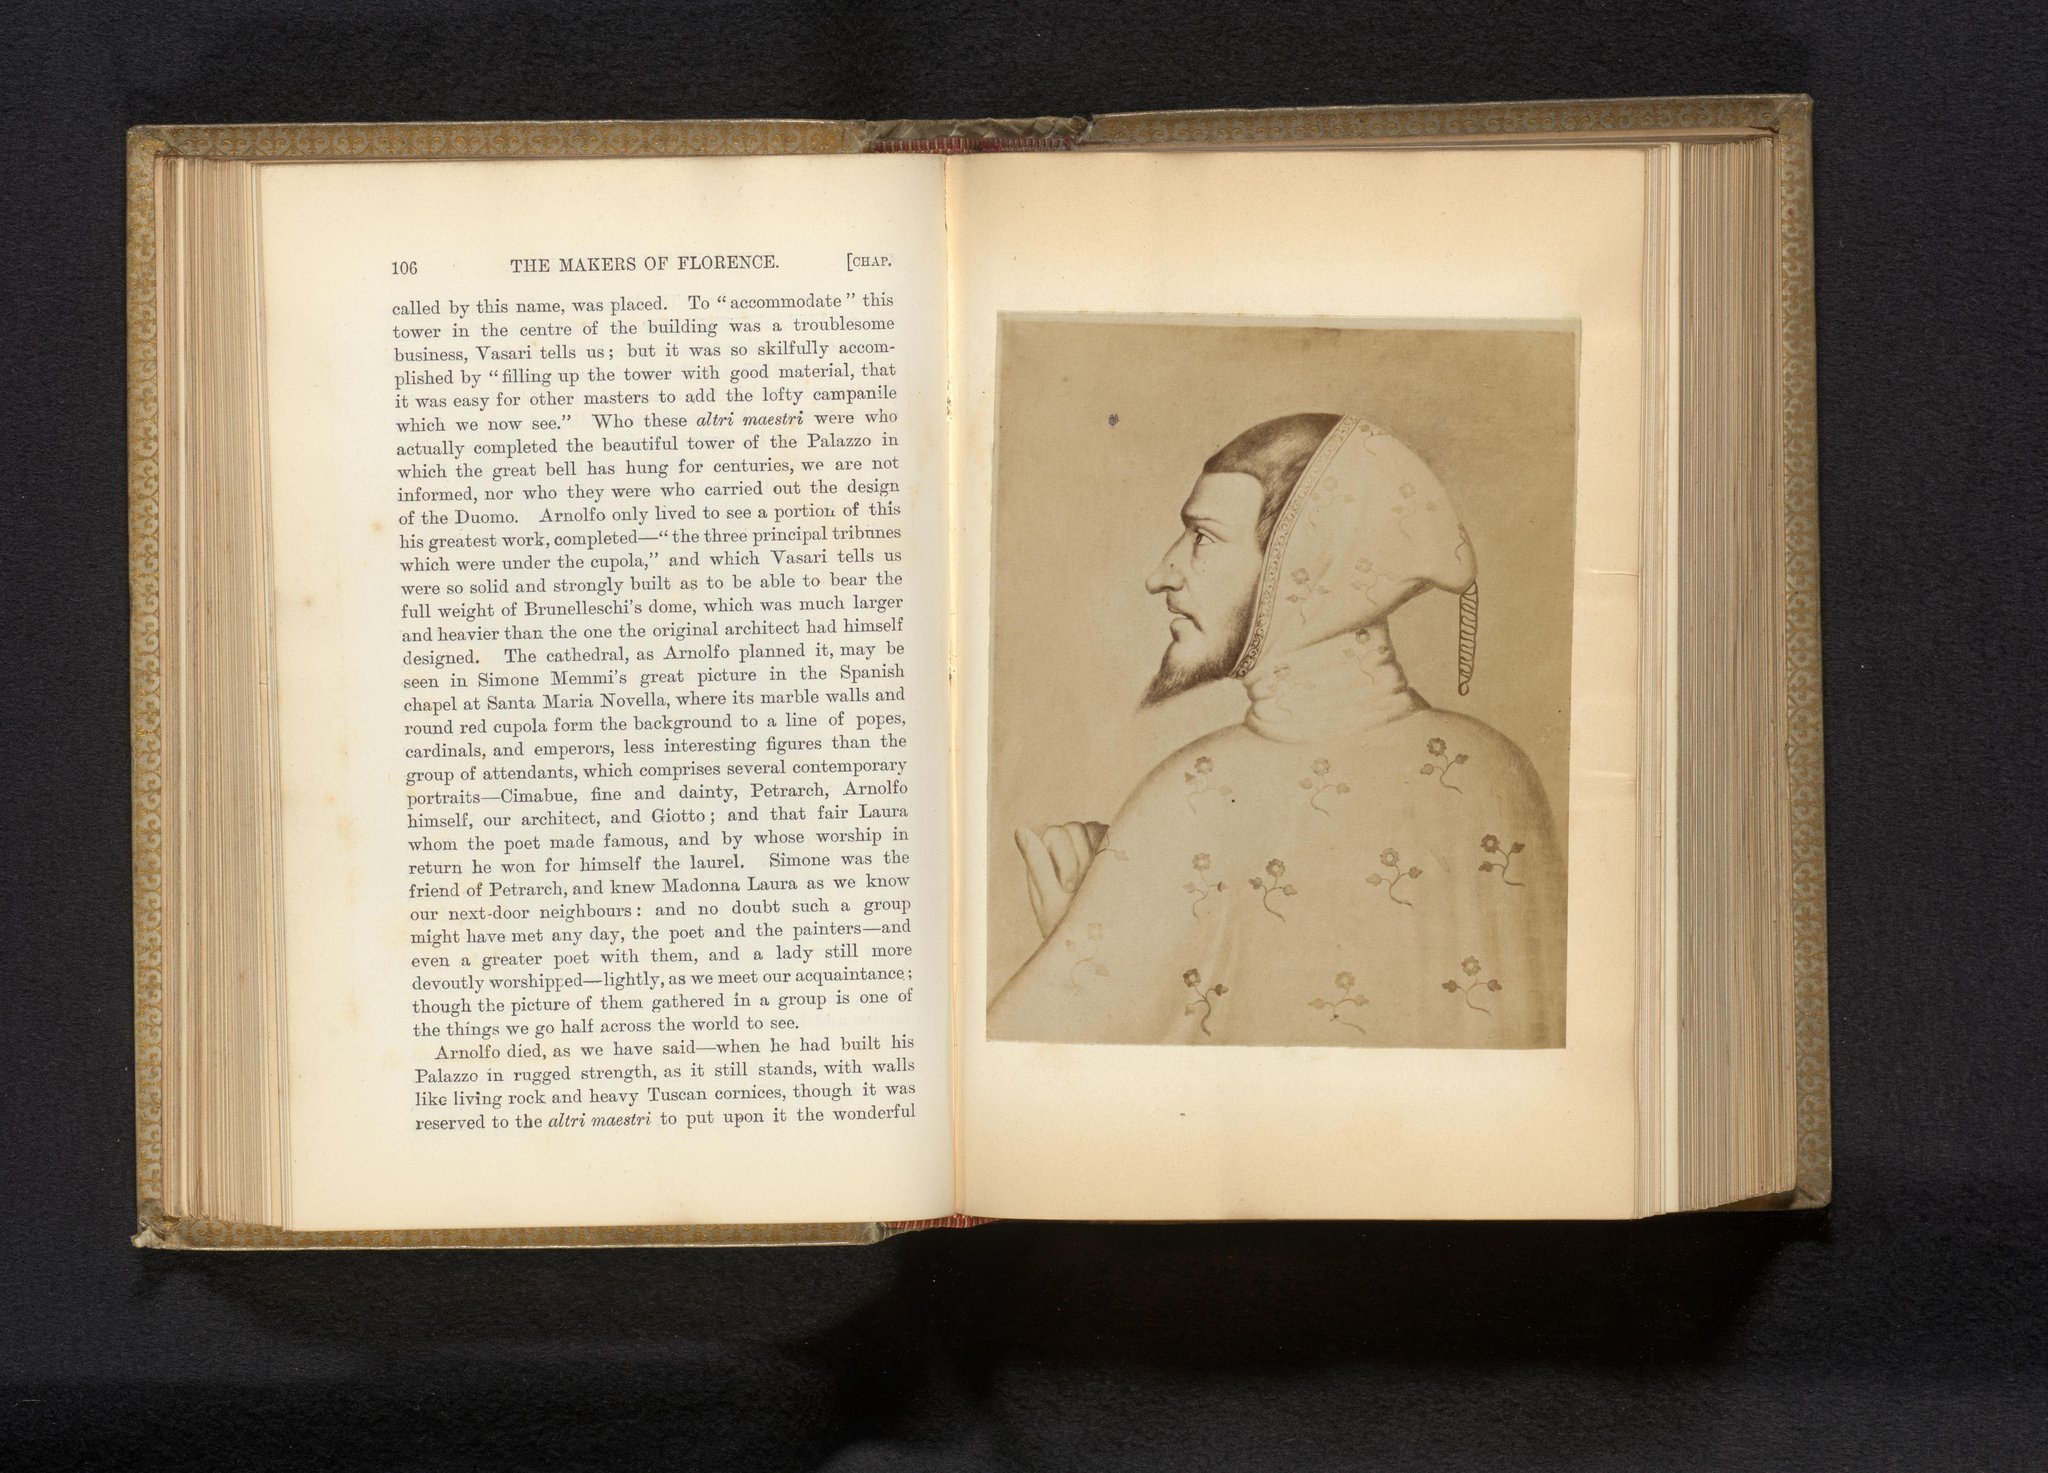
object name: page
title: Fotoreproductie van een fresco, voorstellende een portret van Cimabue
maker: Anonymous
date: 1878-1888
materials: photographic support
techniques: albumen print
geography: florence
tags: cenni di pepo cimabue, portrait, self-portrait of painter